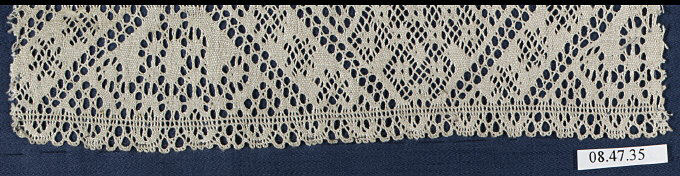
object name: fragment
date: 1801-1900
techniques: lace